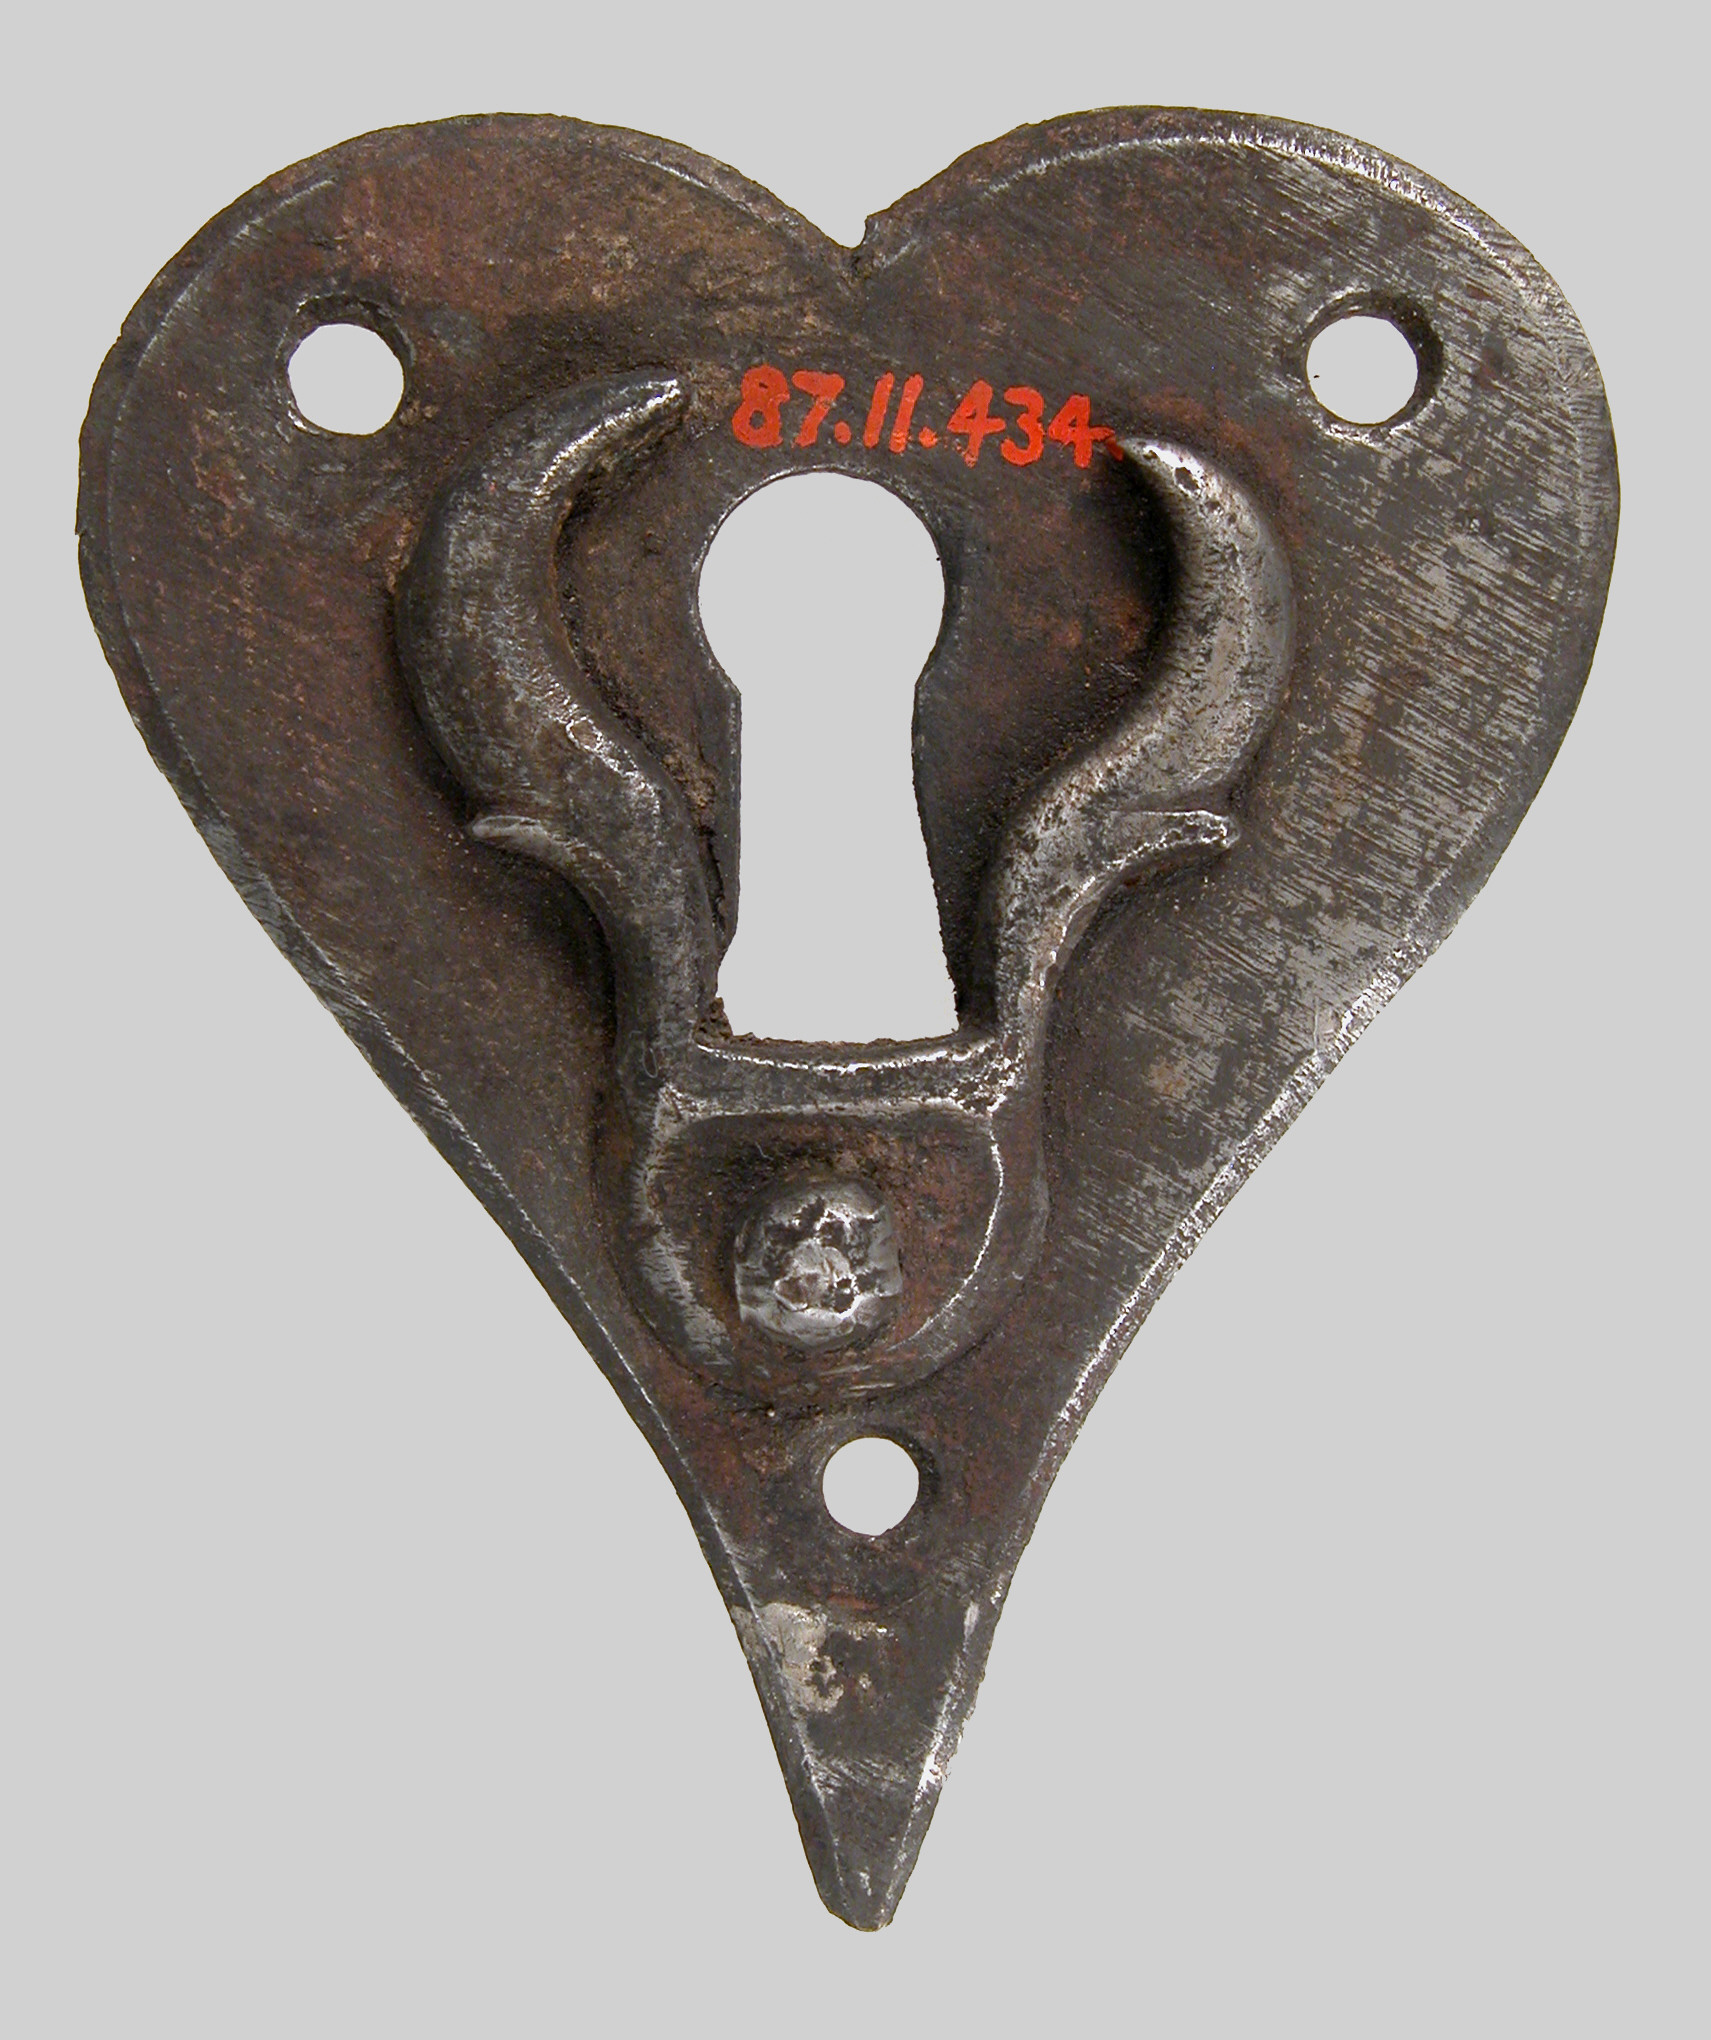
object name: escutcheon plate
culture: german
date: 1501-1600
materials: iron